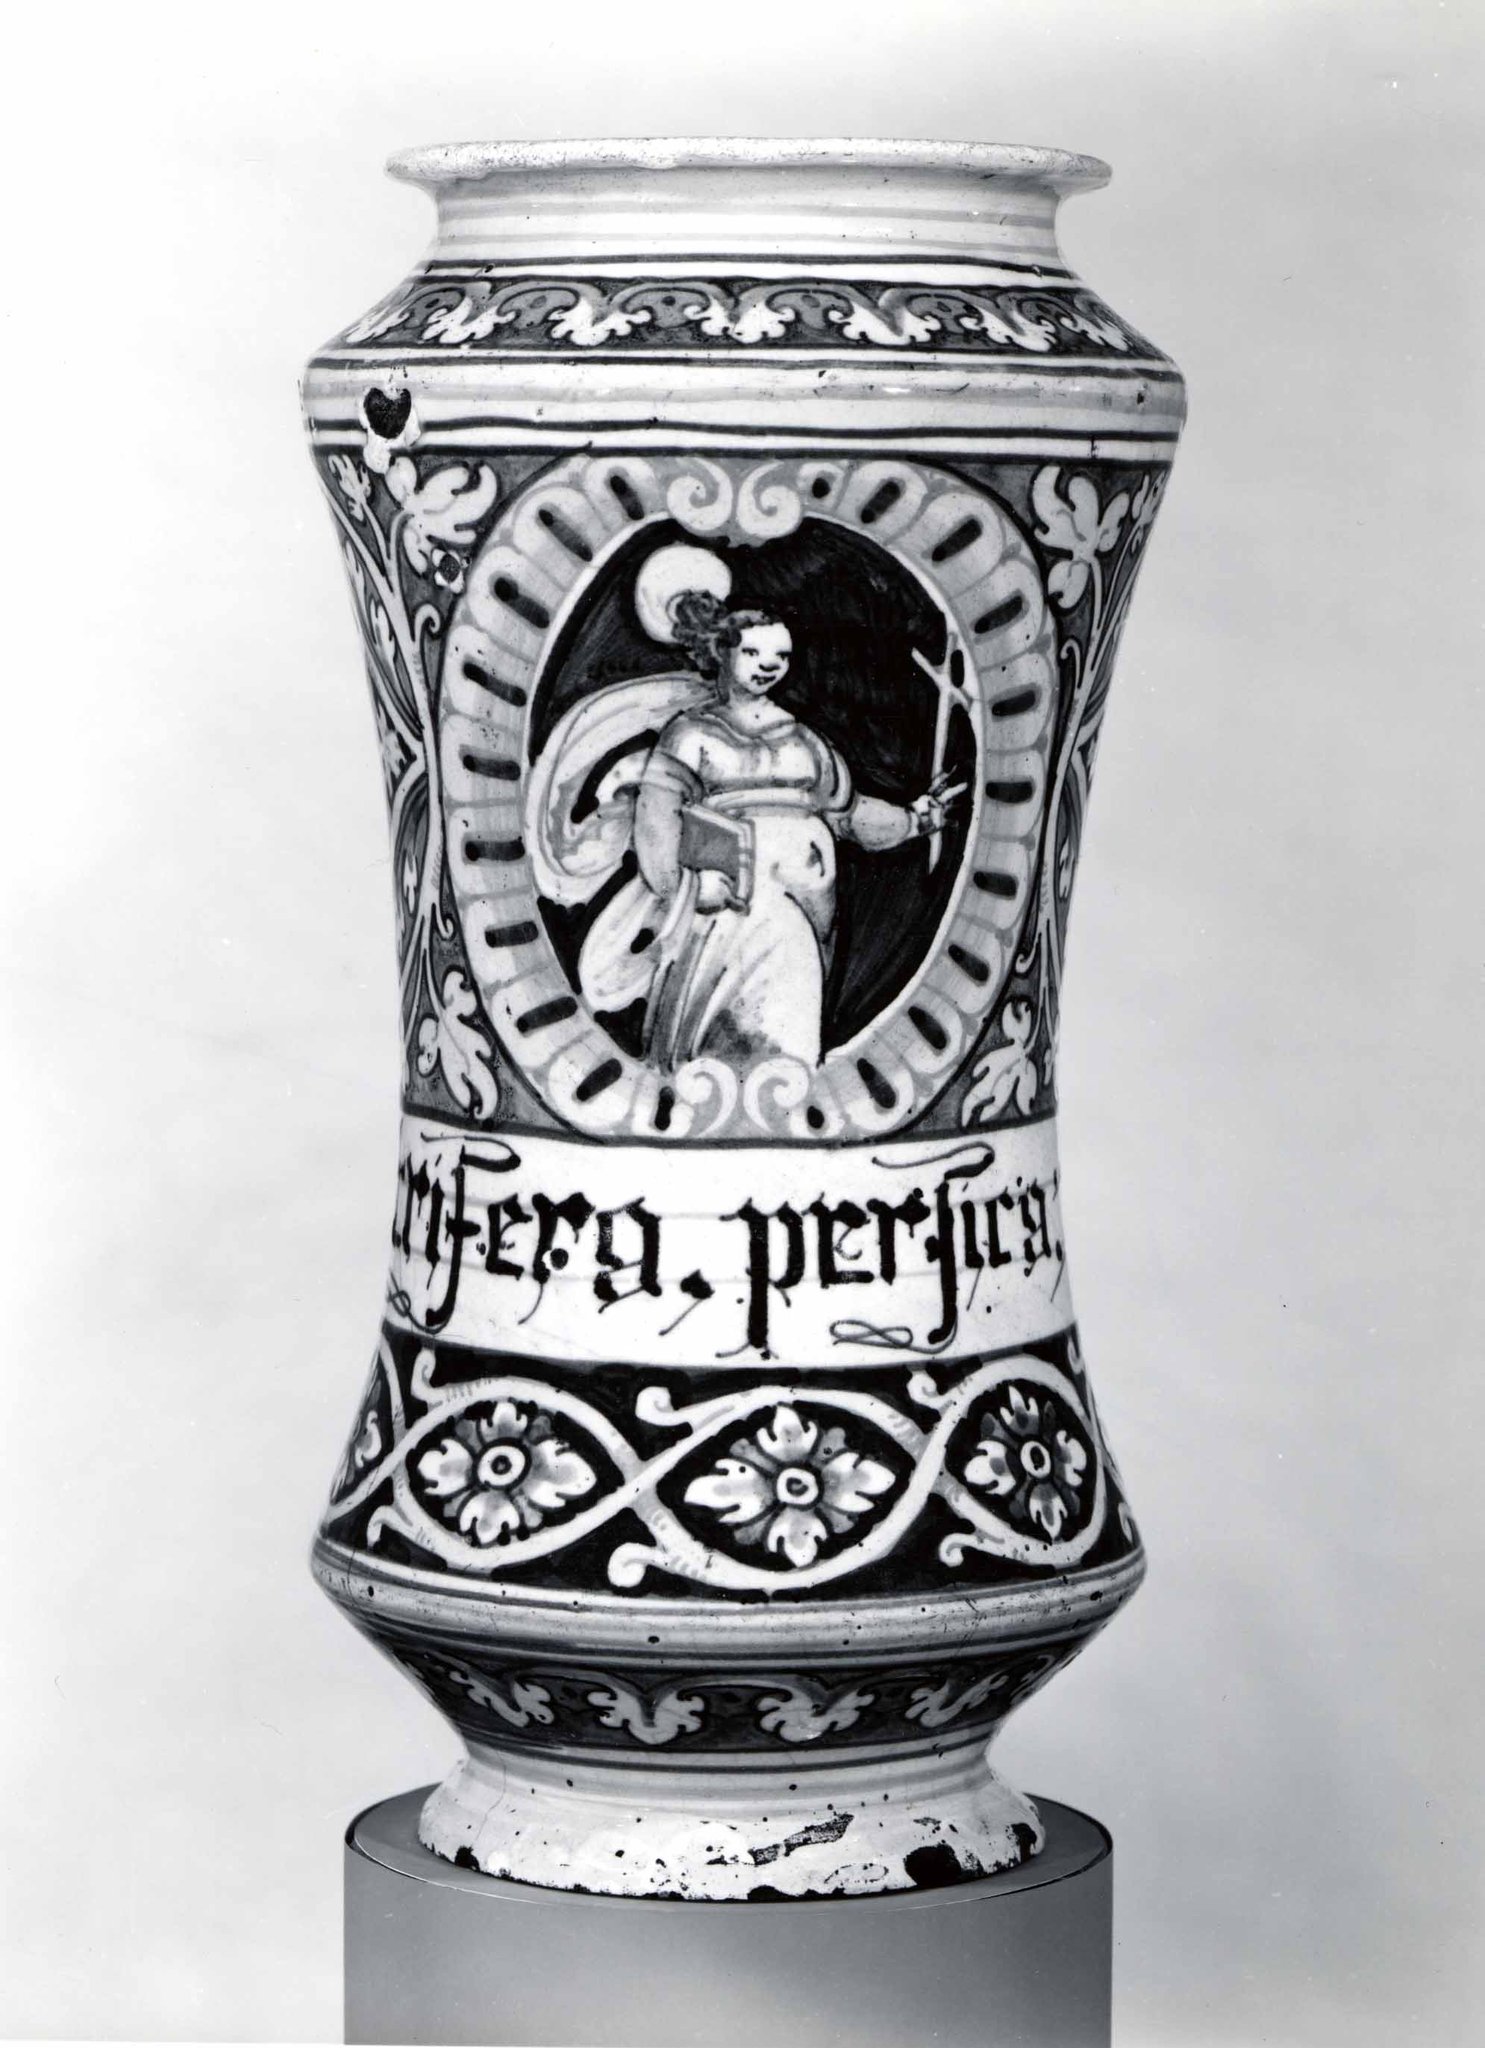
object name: albarello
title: Apothecary jar (albarello)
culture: italian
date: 1550-1600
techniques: maiolica, glazing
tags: women